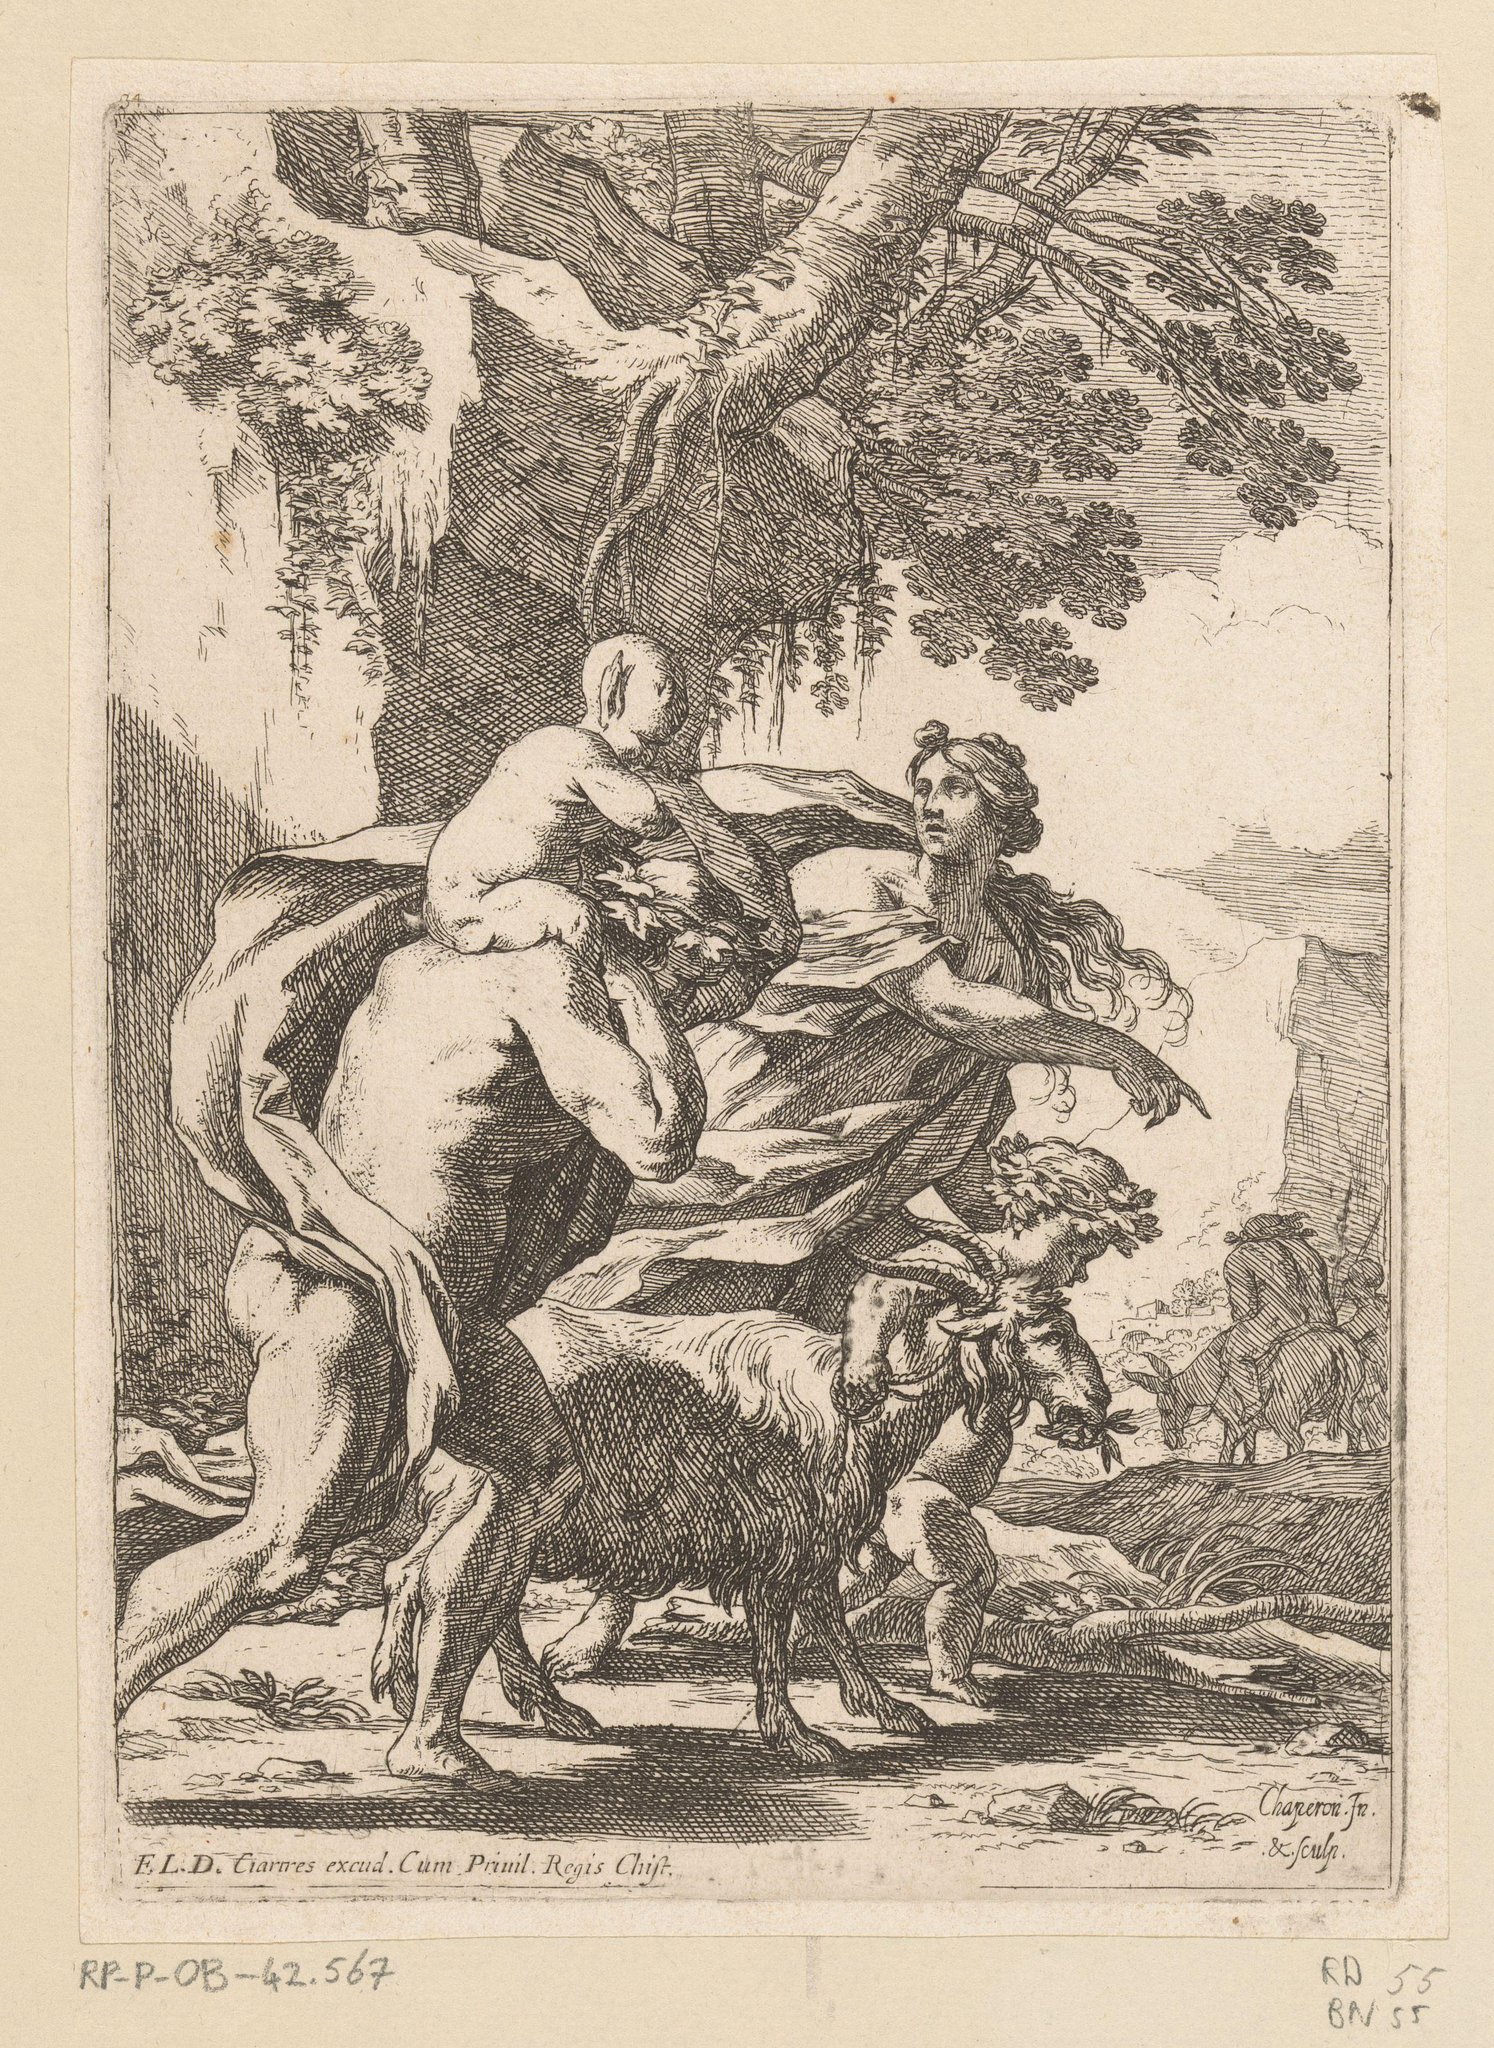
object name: print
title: Volgelingen van Silenus met op de achtergrond Silenus op zijn ezel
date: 1622-1647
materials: paper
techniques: etching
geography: france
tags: (story of) silenus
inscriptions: collector's mark: Lugt 240